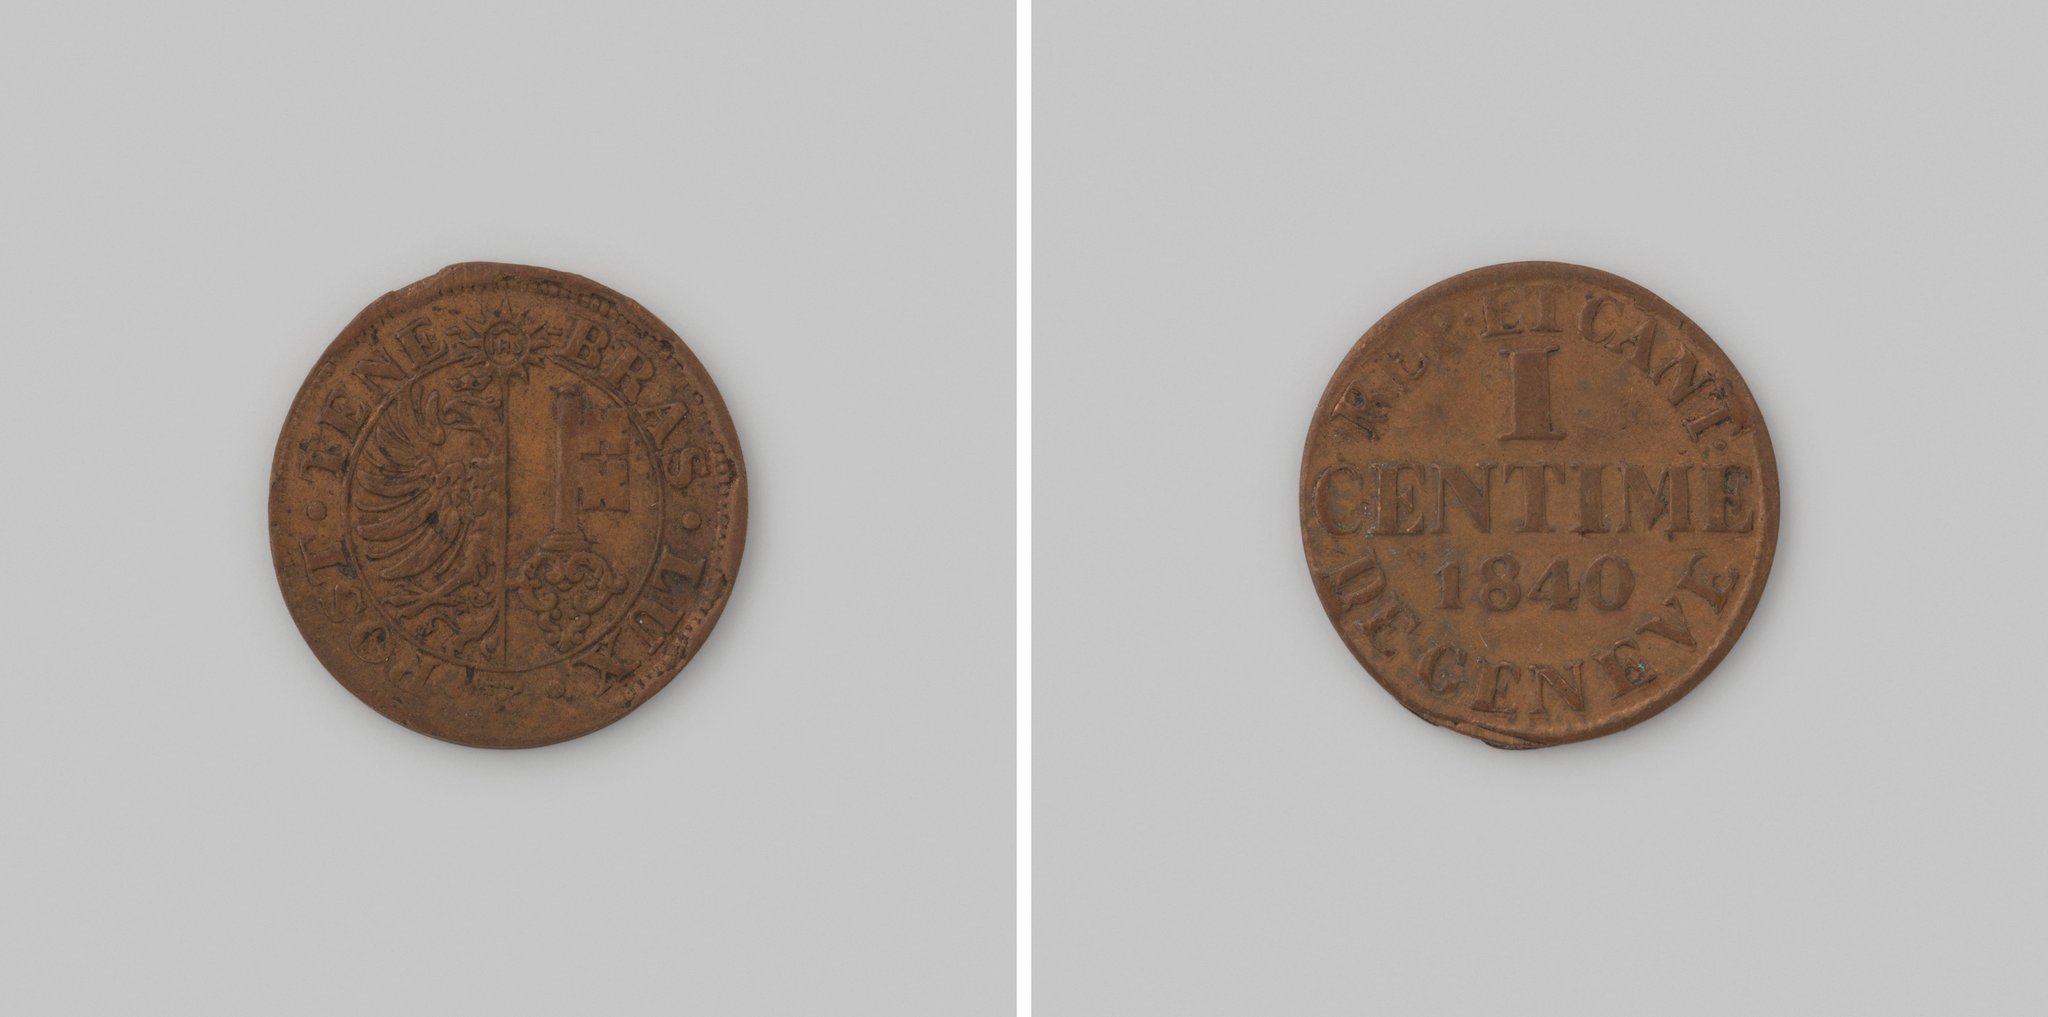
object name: coin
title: Kanton Geneve, centime, 1840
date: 1840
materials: copper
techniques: striking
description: Koperen munt. Voorzijde: wapen van Geneve in het veld. Daarboven binnen stralende zon de letters I,H en S. Keerzijde: waarde-aanduiding in twee regels, waaronder jaartal. Gladde rand.